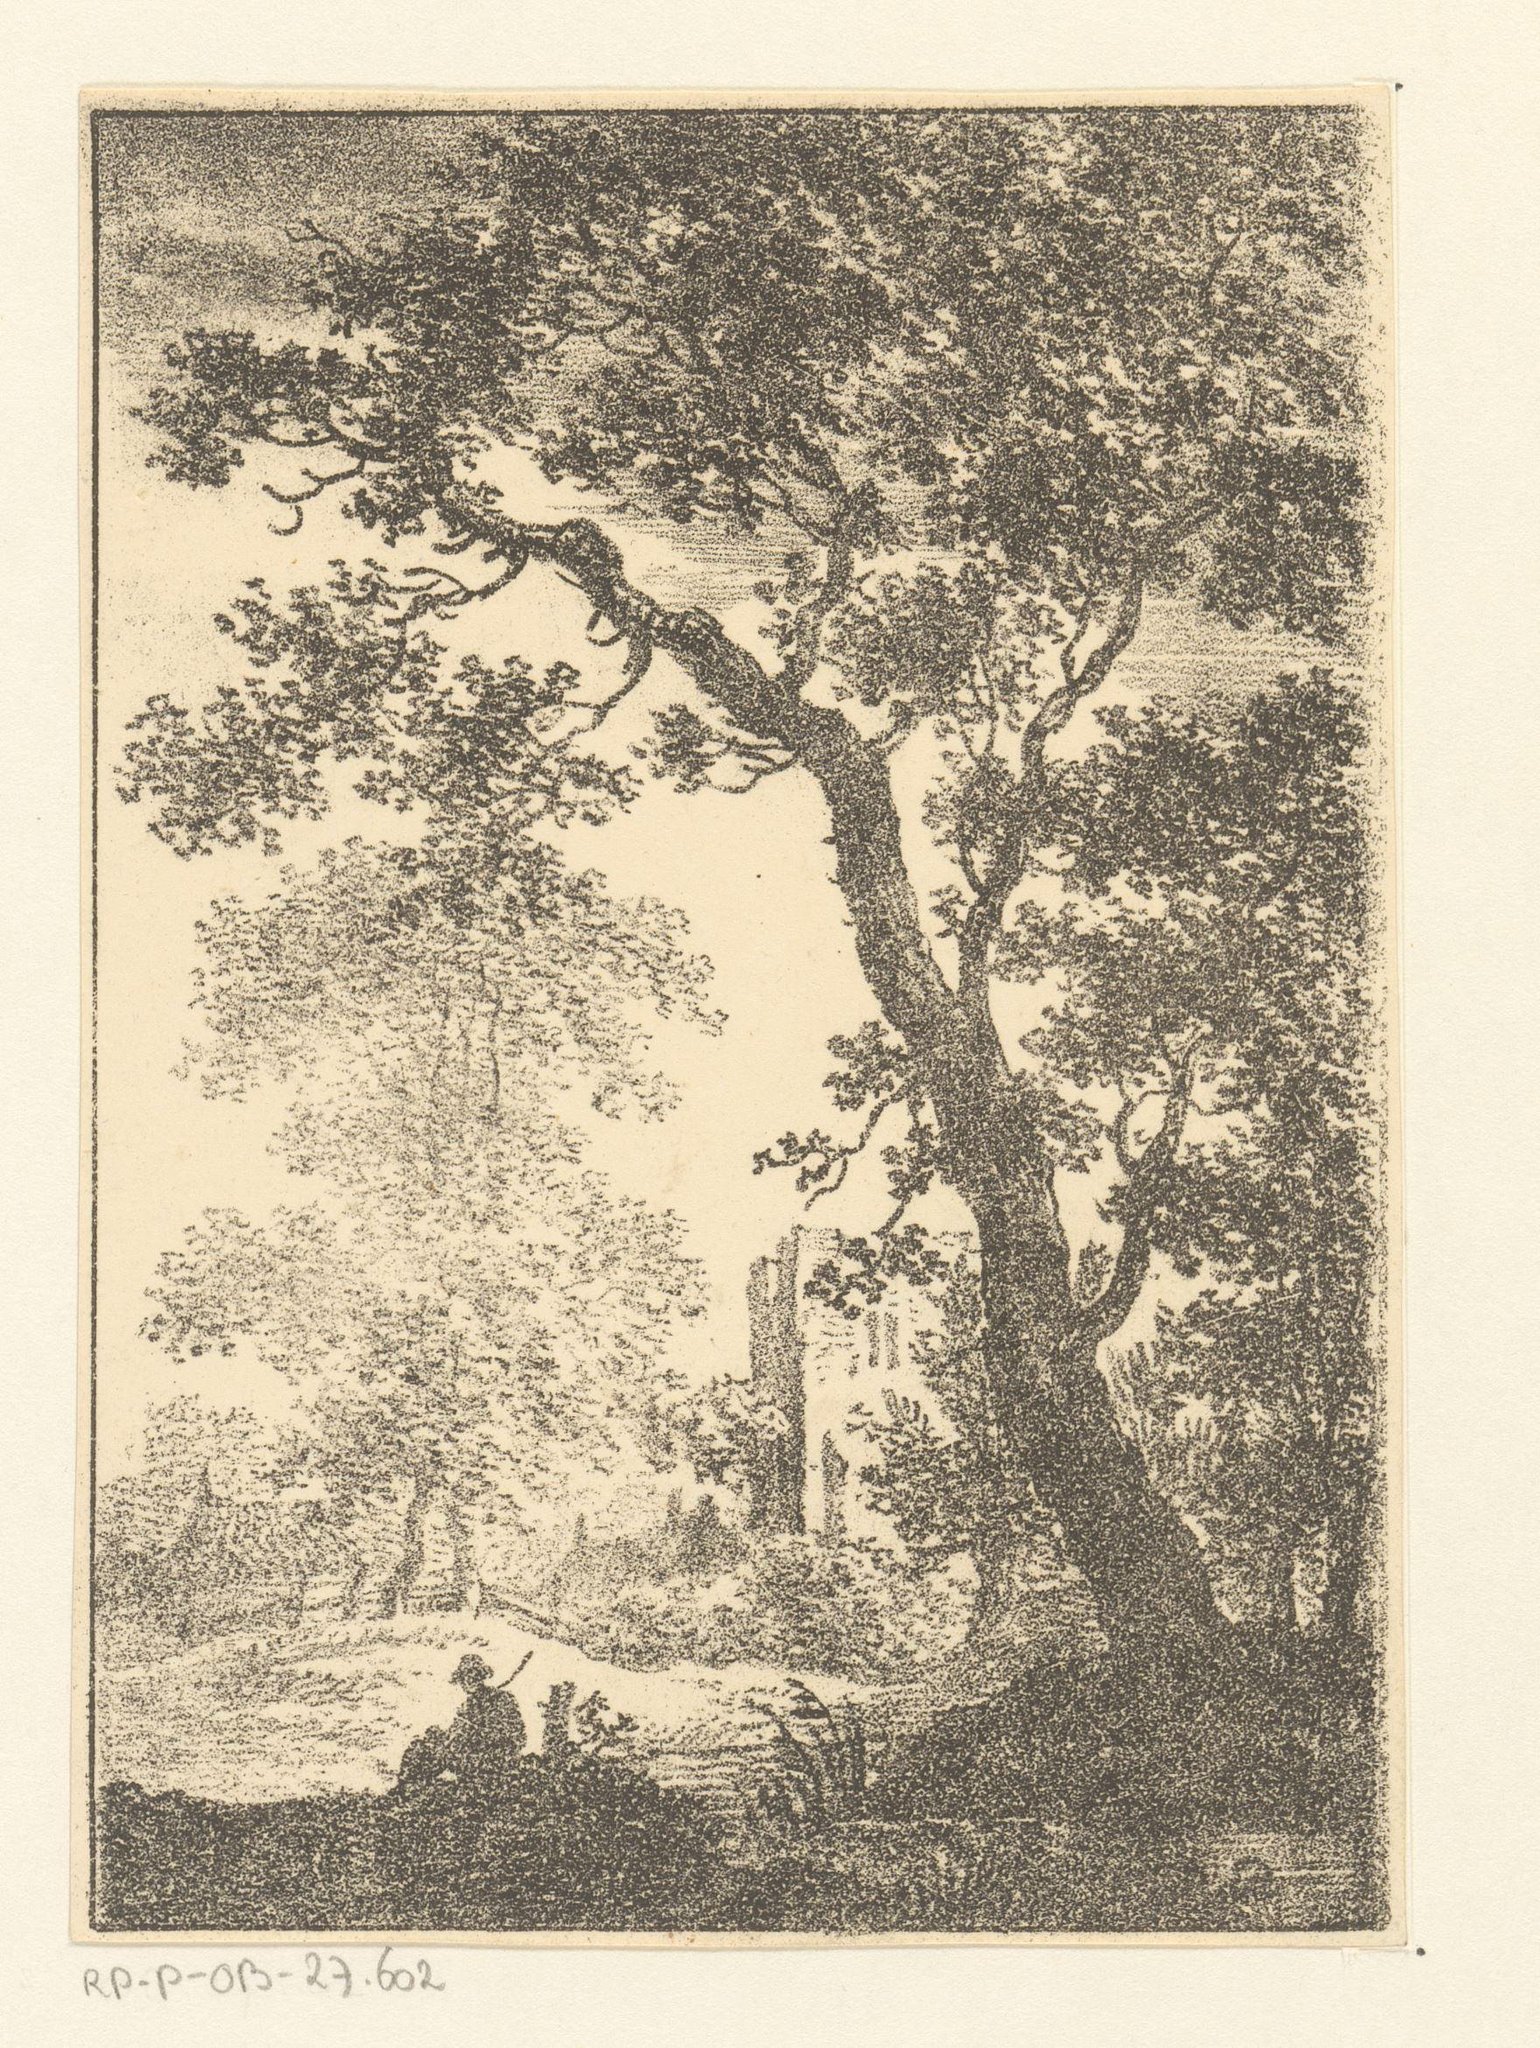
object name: print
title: Landschap met ruïne en zittende figuur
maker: pieter bartholomeusz. barbiers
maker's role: draughtsman, print maker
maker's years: 1772-1837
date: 1809-1837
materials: paper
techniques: lithograph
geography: haarlem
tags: landscapes (+ landscape with figures, staffage)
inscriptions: collector's mark: Lugt 2228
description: Onder een boom zit een figuur met een wandelstok. Tussen de bomen een ruïne en een boerderij.